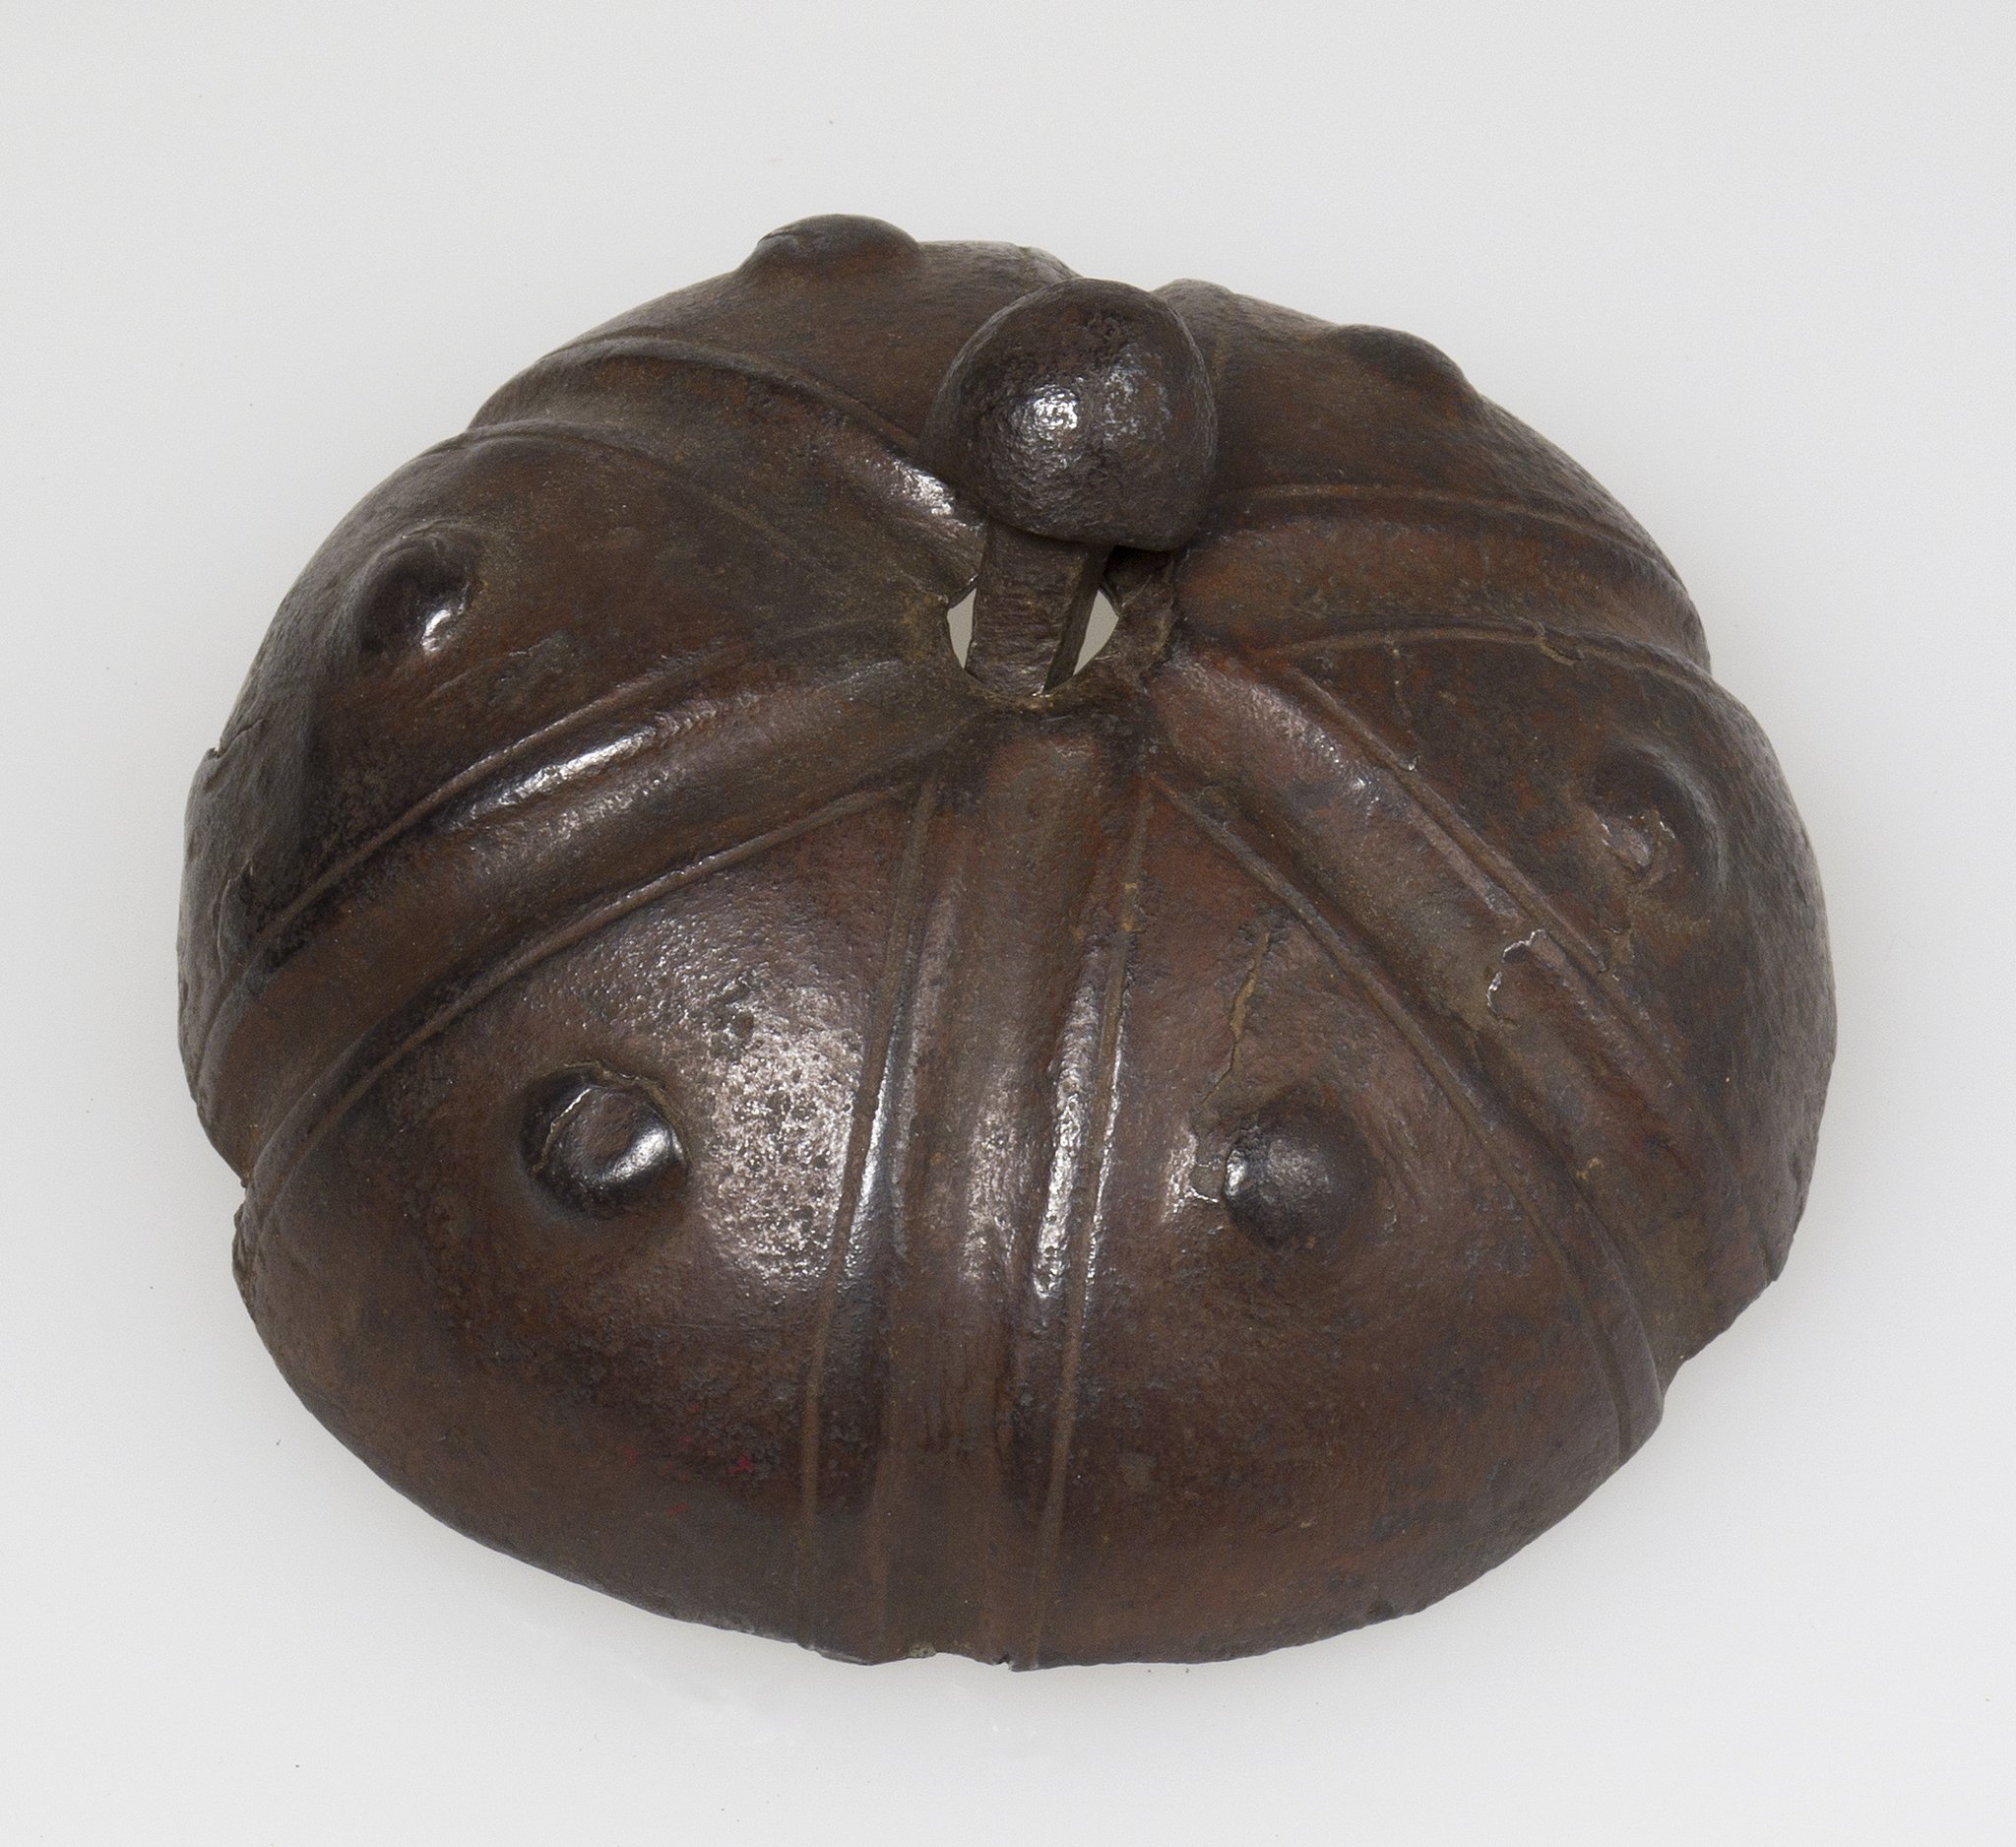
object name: bos and nail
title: Boss and Nail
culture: european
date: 1401-1600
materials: iron